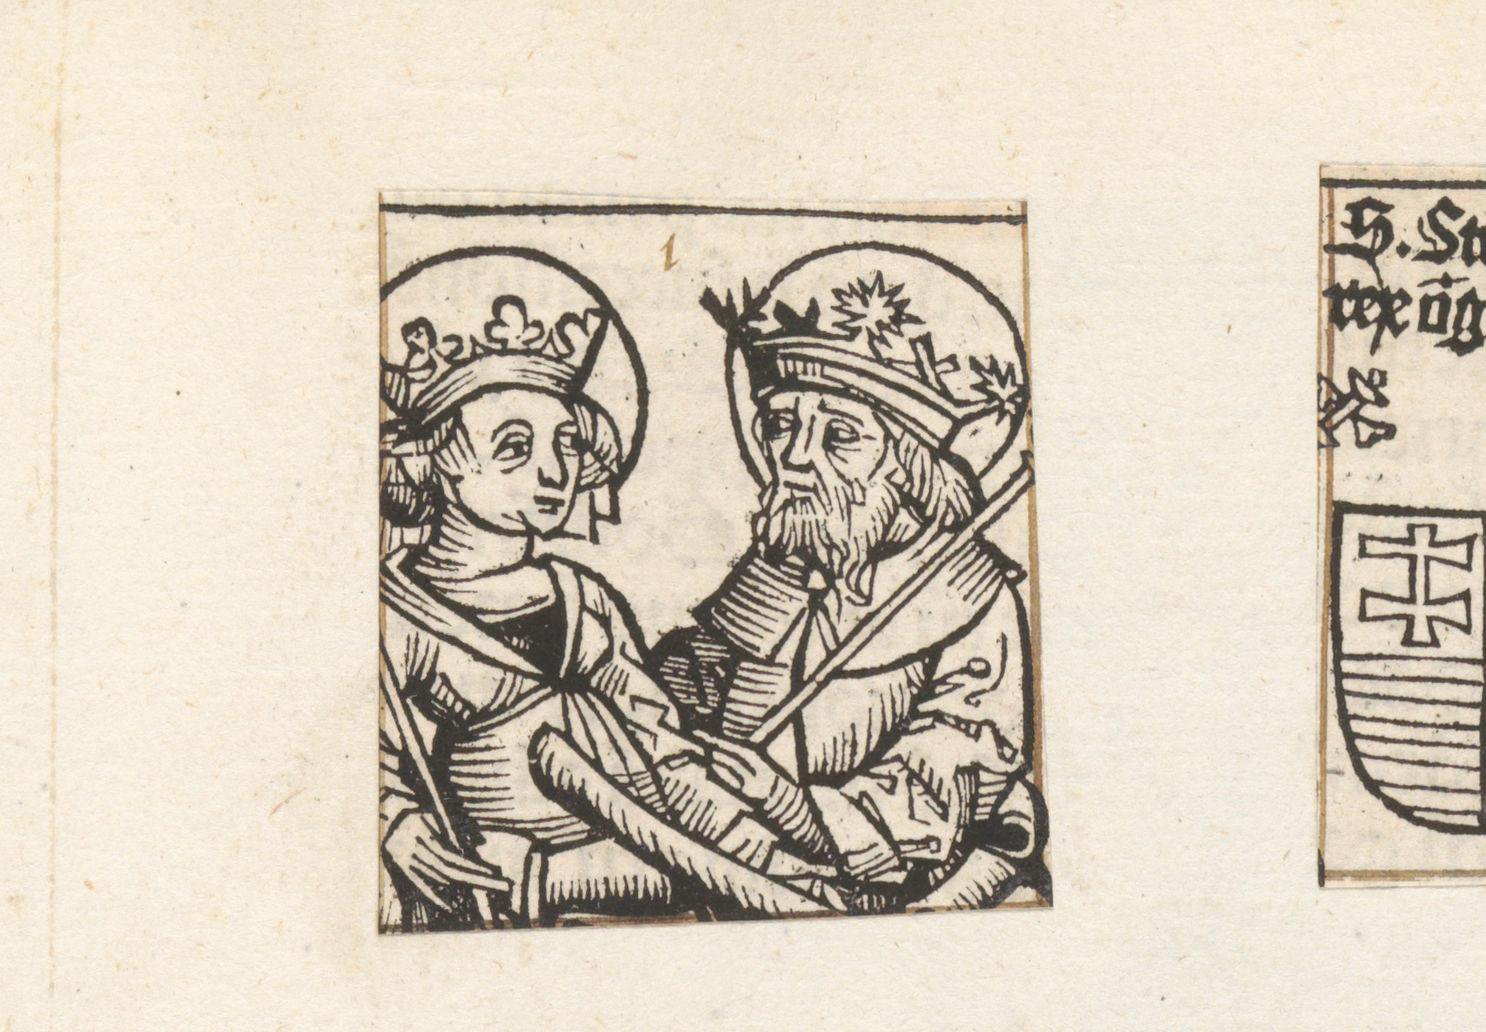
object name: album leaf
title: Gisela van Beieren en Stefanus I van Hongarije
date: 1493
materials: paper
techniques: woodcut, pasting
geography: nuremberg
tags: queen, empress, etc. (wife of a ruler), king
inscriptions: inscription: ‘1’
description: Een koning en koningin. De voorstelling is onderdeel van de stamboom van keizer Hendrik II de Heilige in de Liber Chronicarum. De tekst identificeert het paar als Gisela van Beieren en Stefanus I van Hongarije. De prent maakt deel uit van een album.